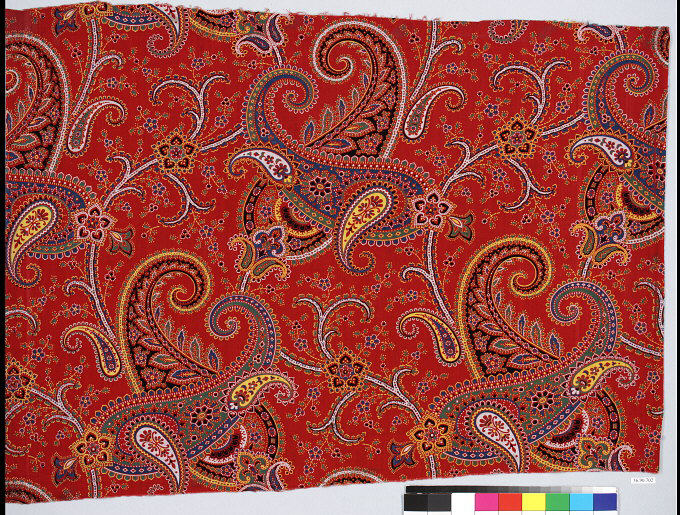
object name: piece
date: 1867-1900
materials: cotton